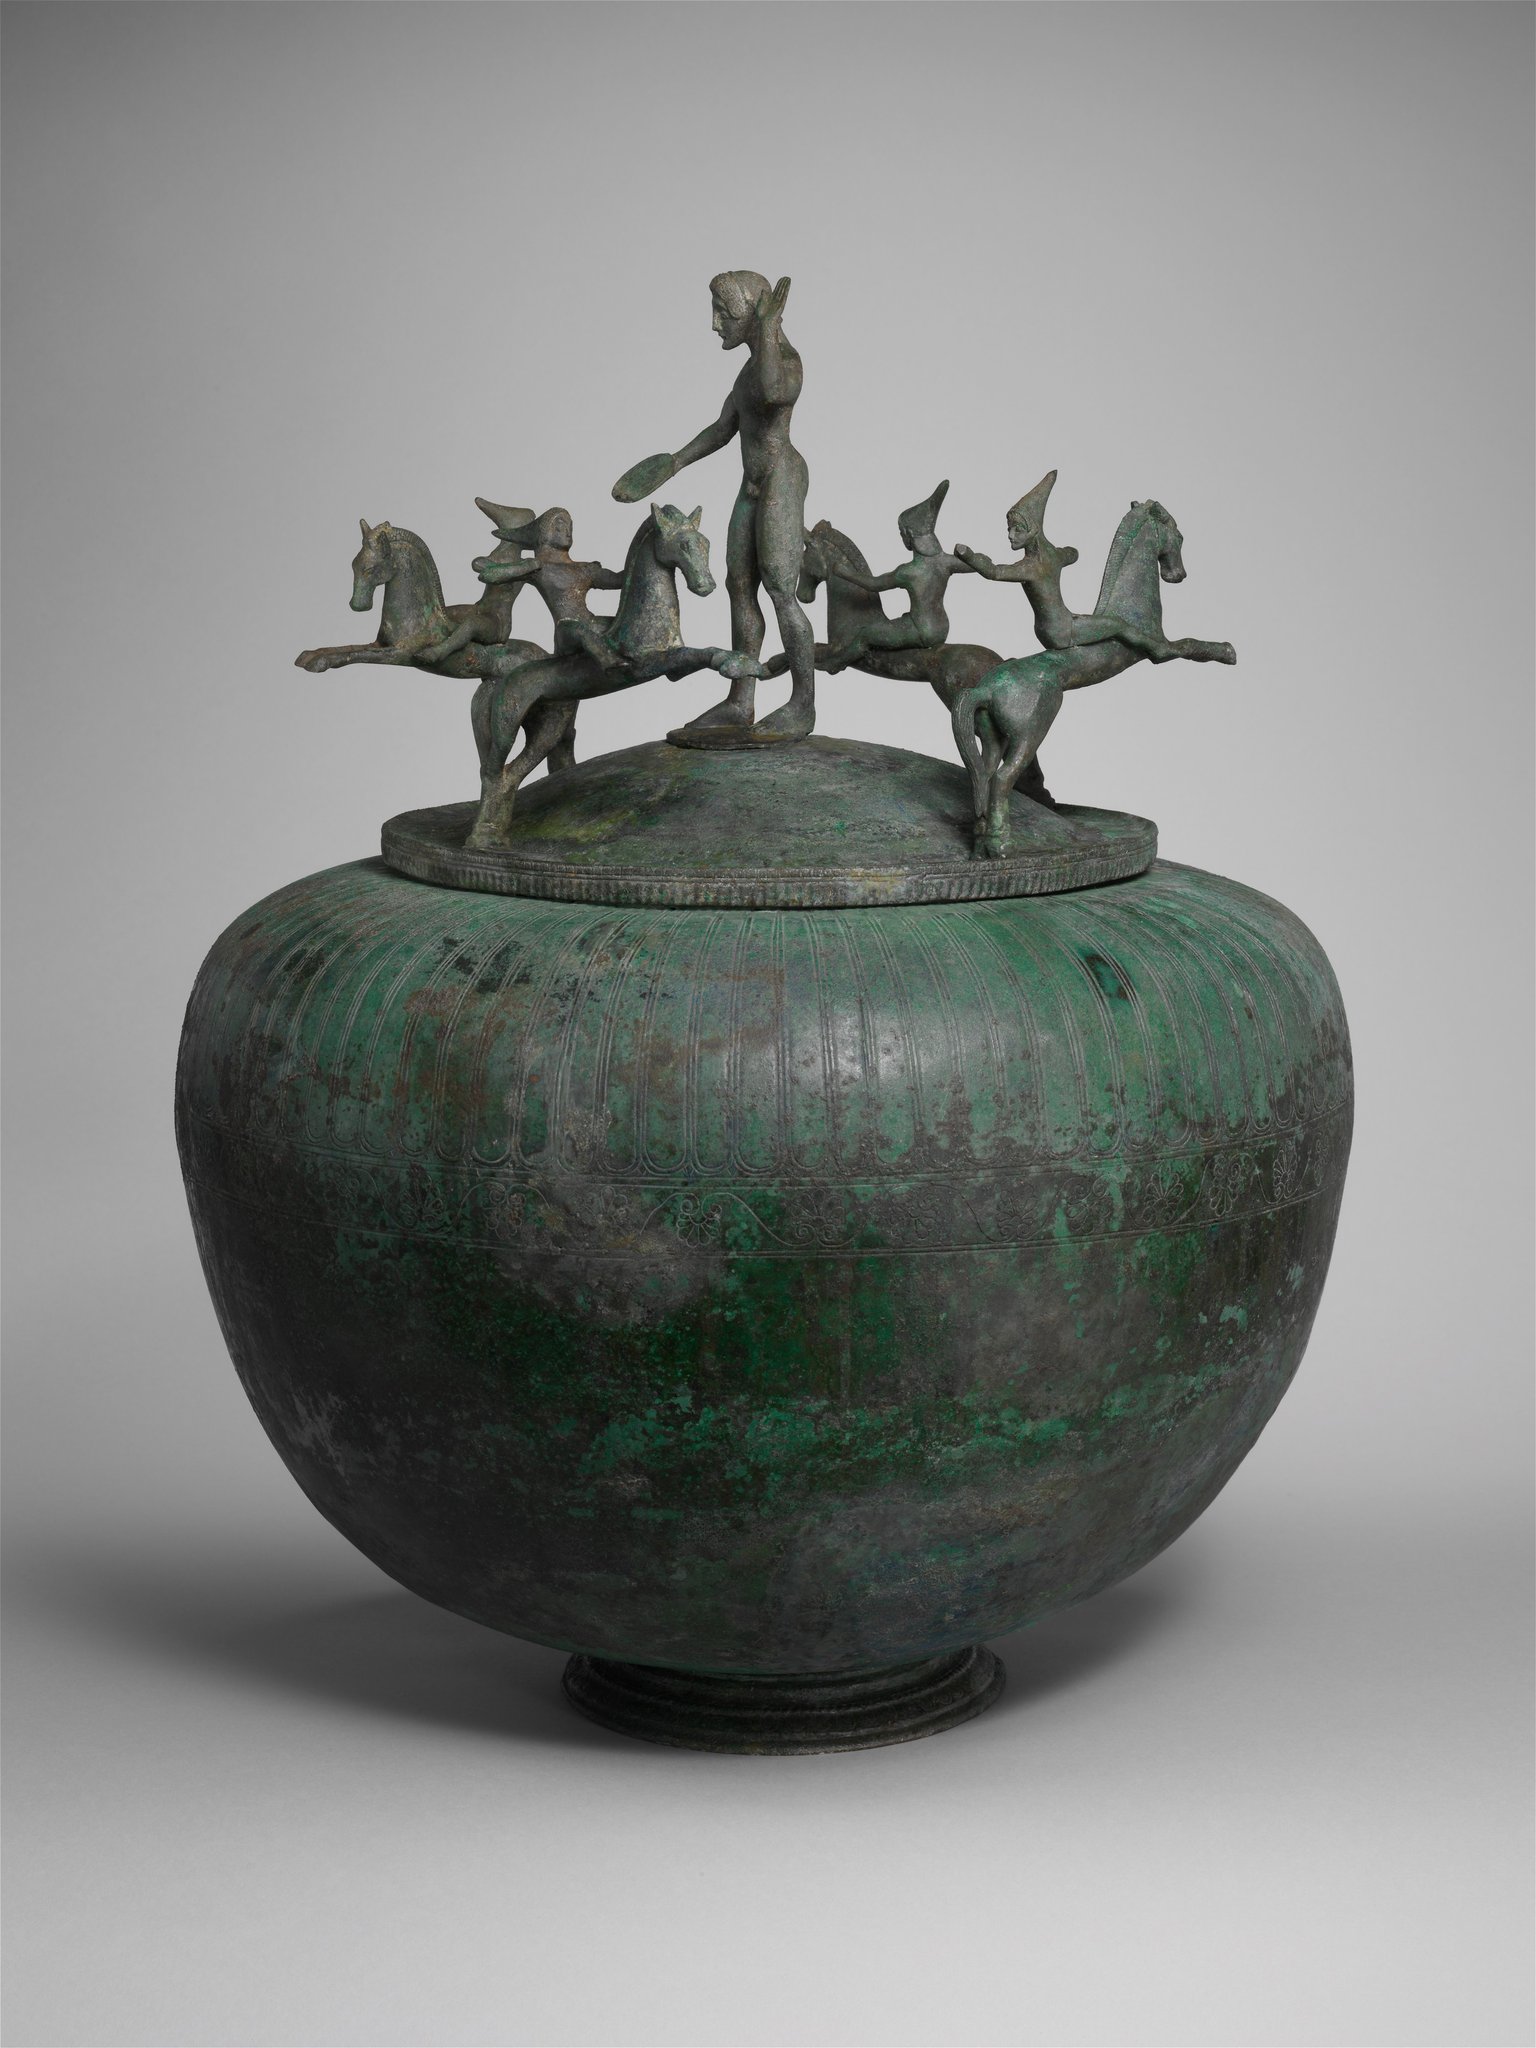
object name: cinerary urn with lid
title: Bronze cinerary urn with lid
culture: etruscan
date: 500 BCE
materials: bronze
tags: male nudes,horses